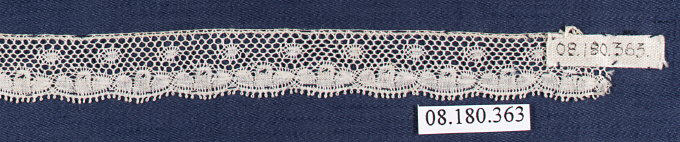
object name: fragment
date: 1701-1800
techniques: lace